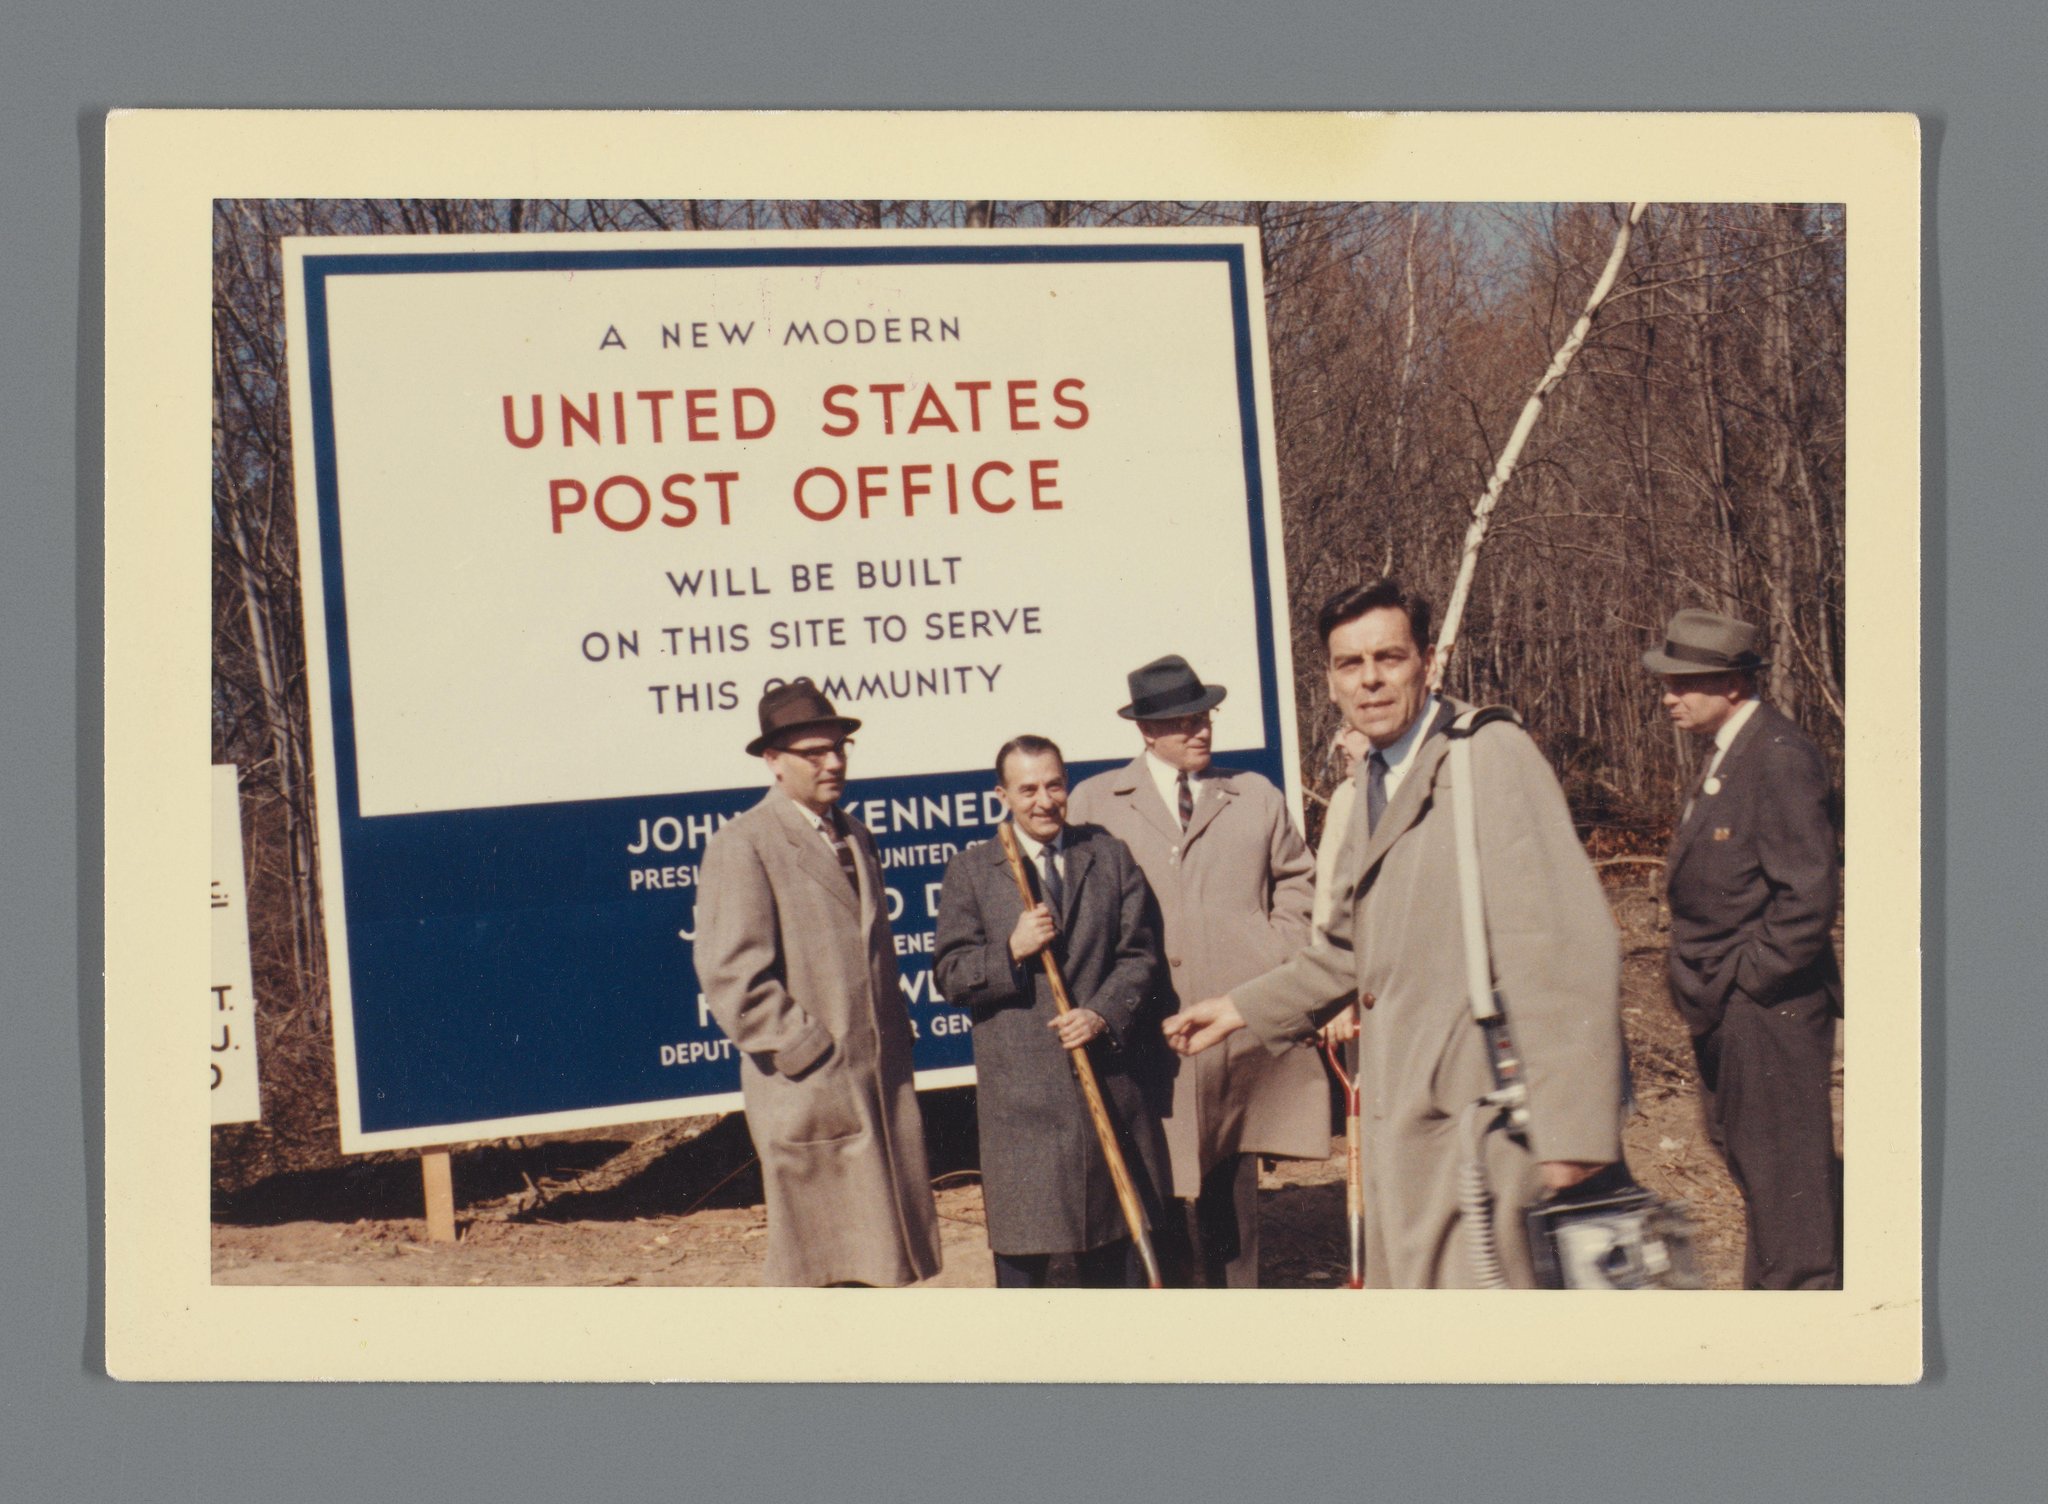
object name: photograph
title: Groep mannen waaronder een met taperecorder bij een bord dat de bouw van een nieuw modern United States Post Office aankondigt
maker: Anonymous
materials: photographic support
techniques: chromogenic print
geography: united states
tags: united states of america